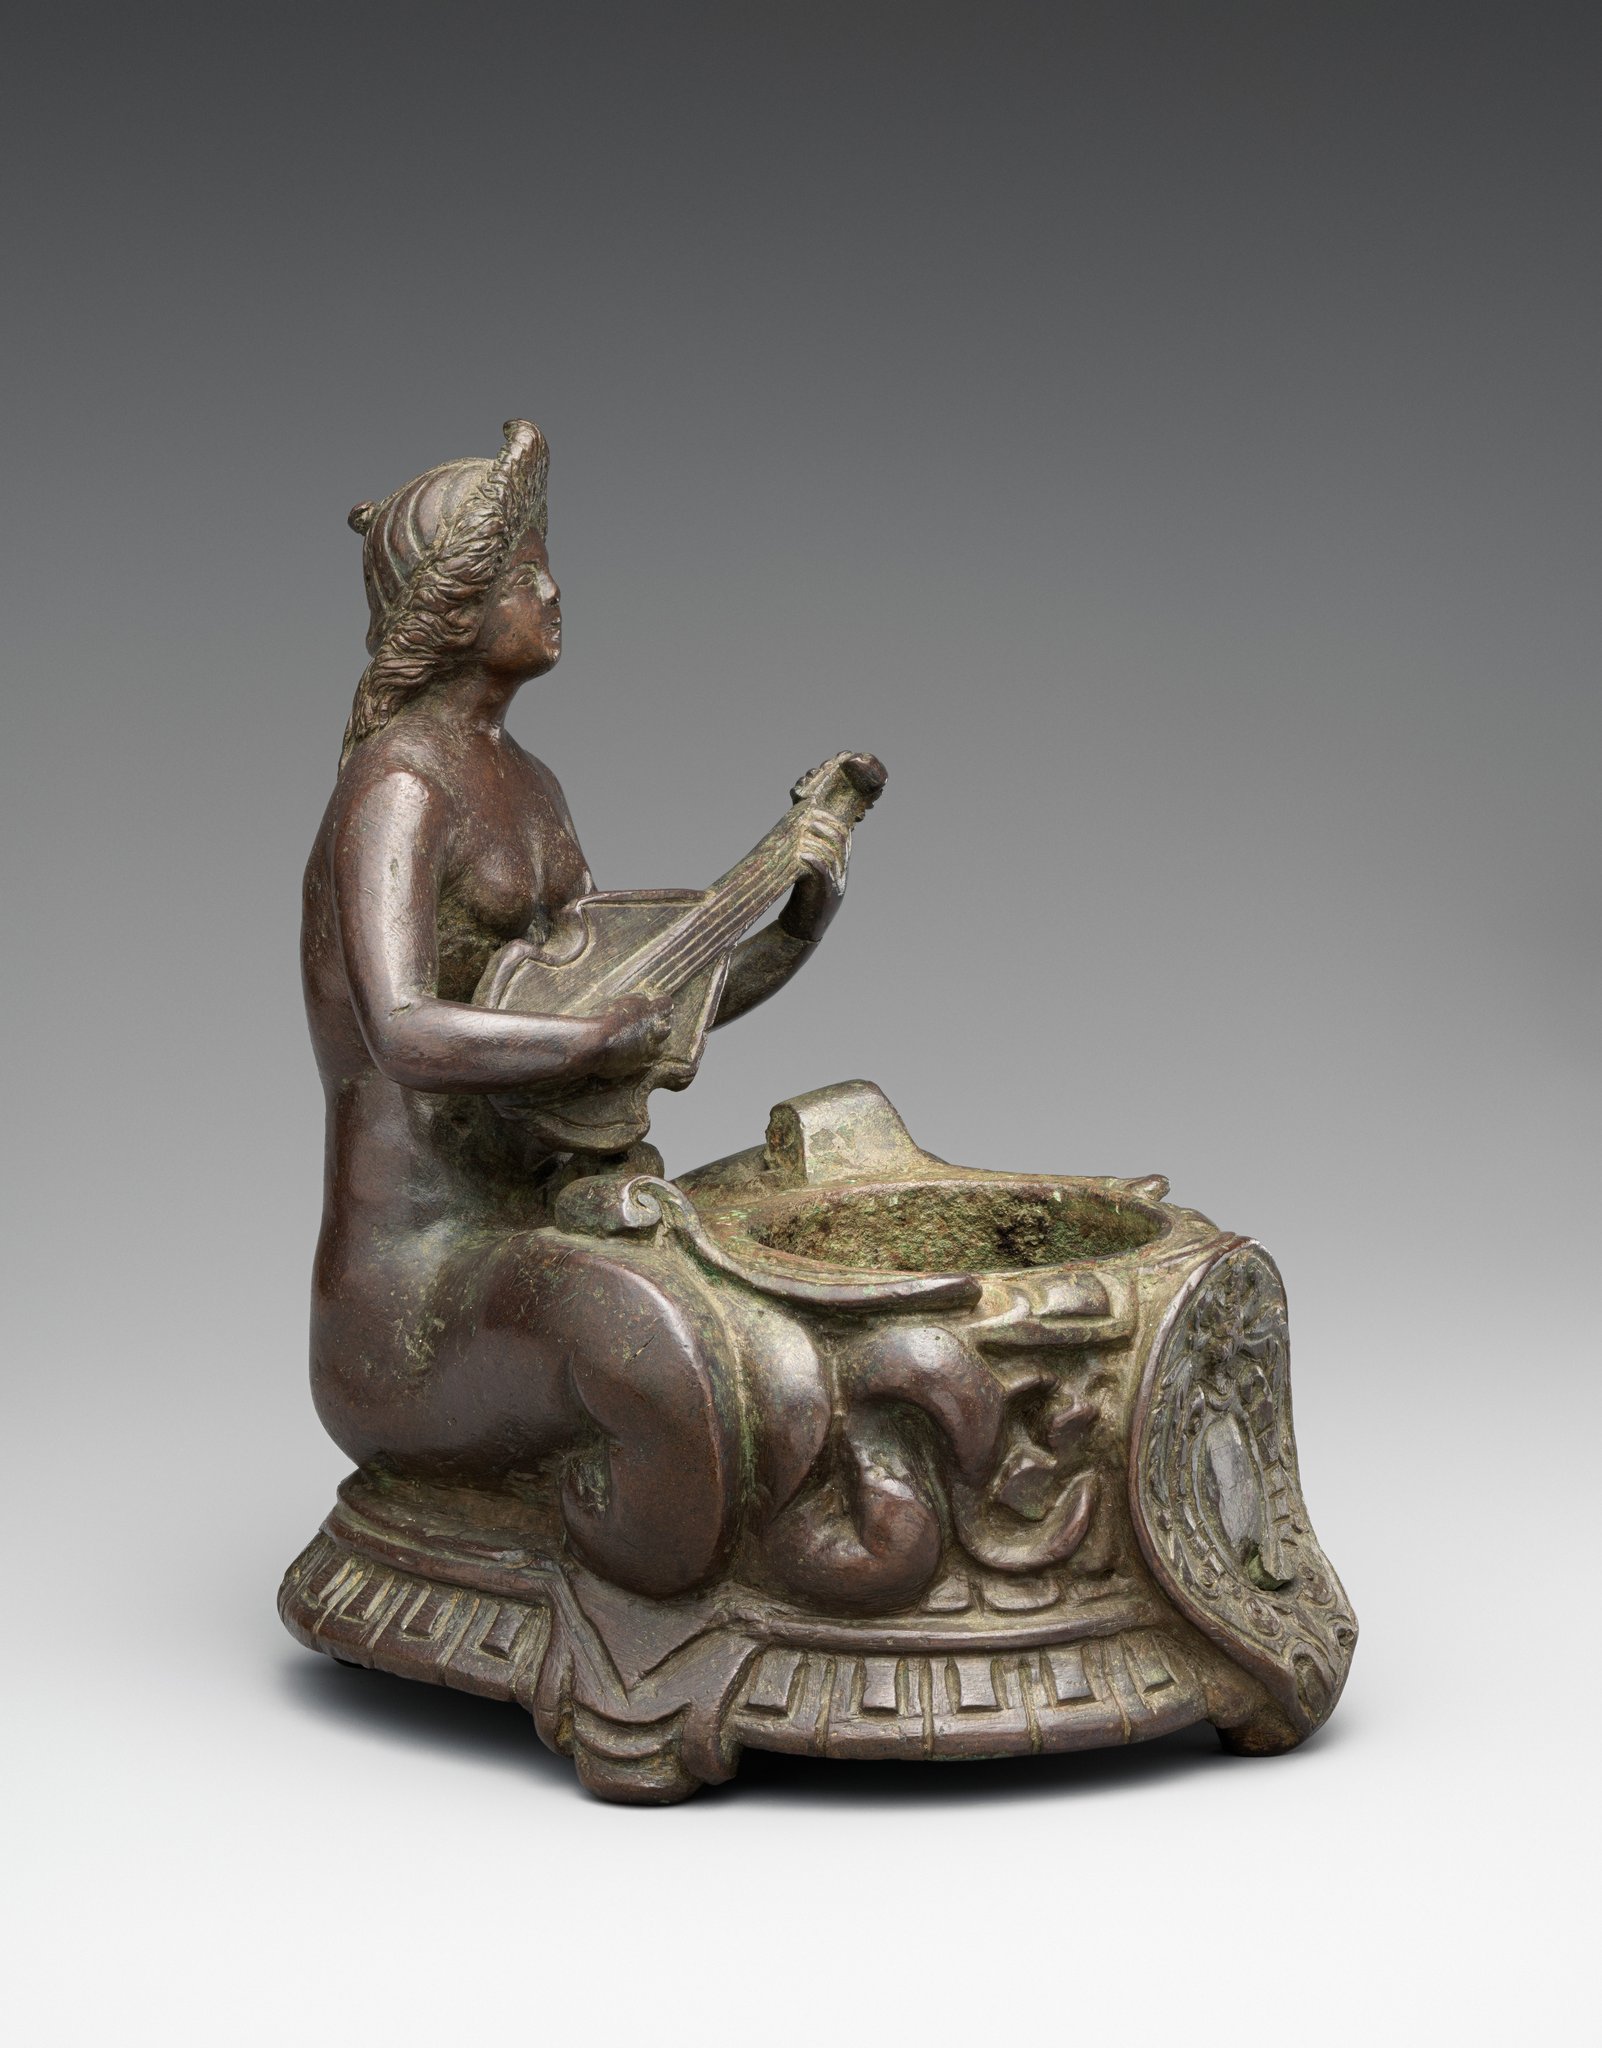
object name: inkstand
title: Mermaid playing a lute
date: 1550-1600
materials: bronze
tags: lutes,mermaids